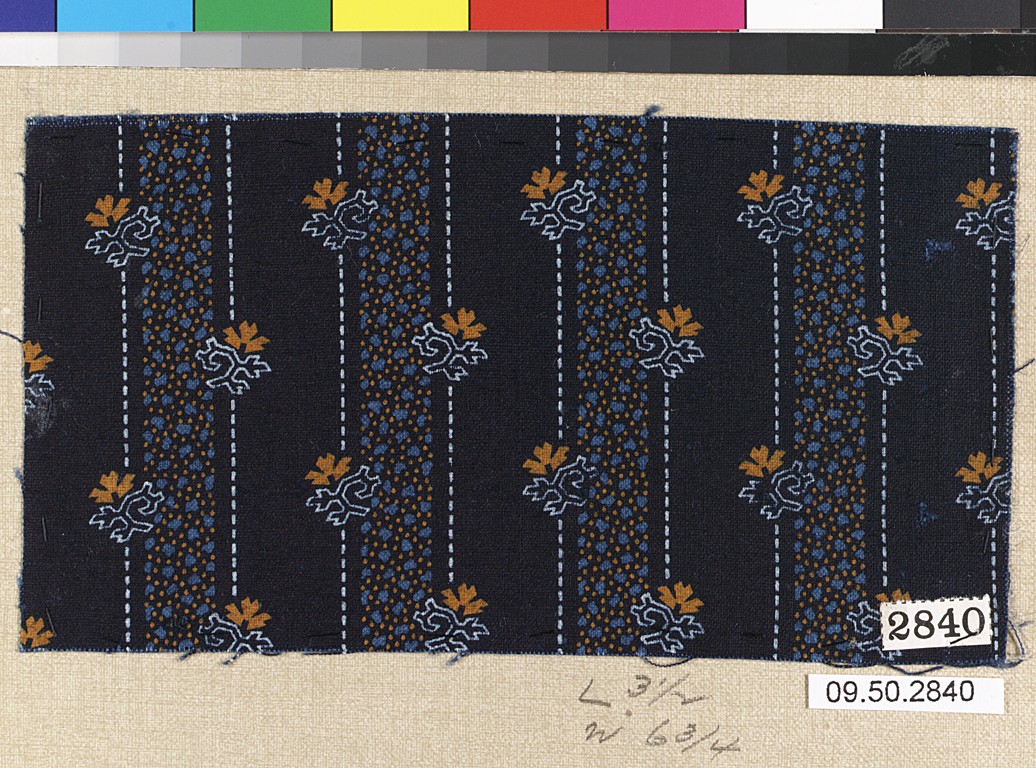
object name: piece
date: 1801-1900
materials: cotton